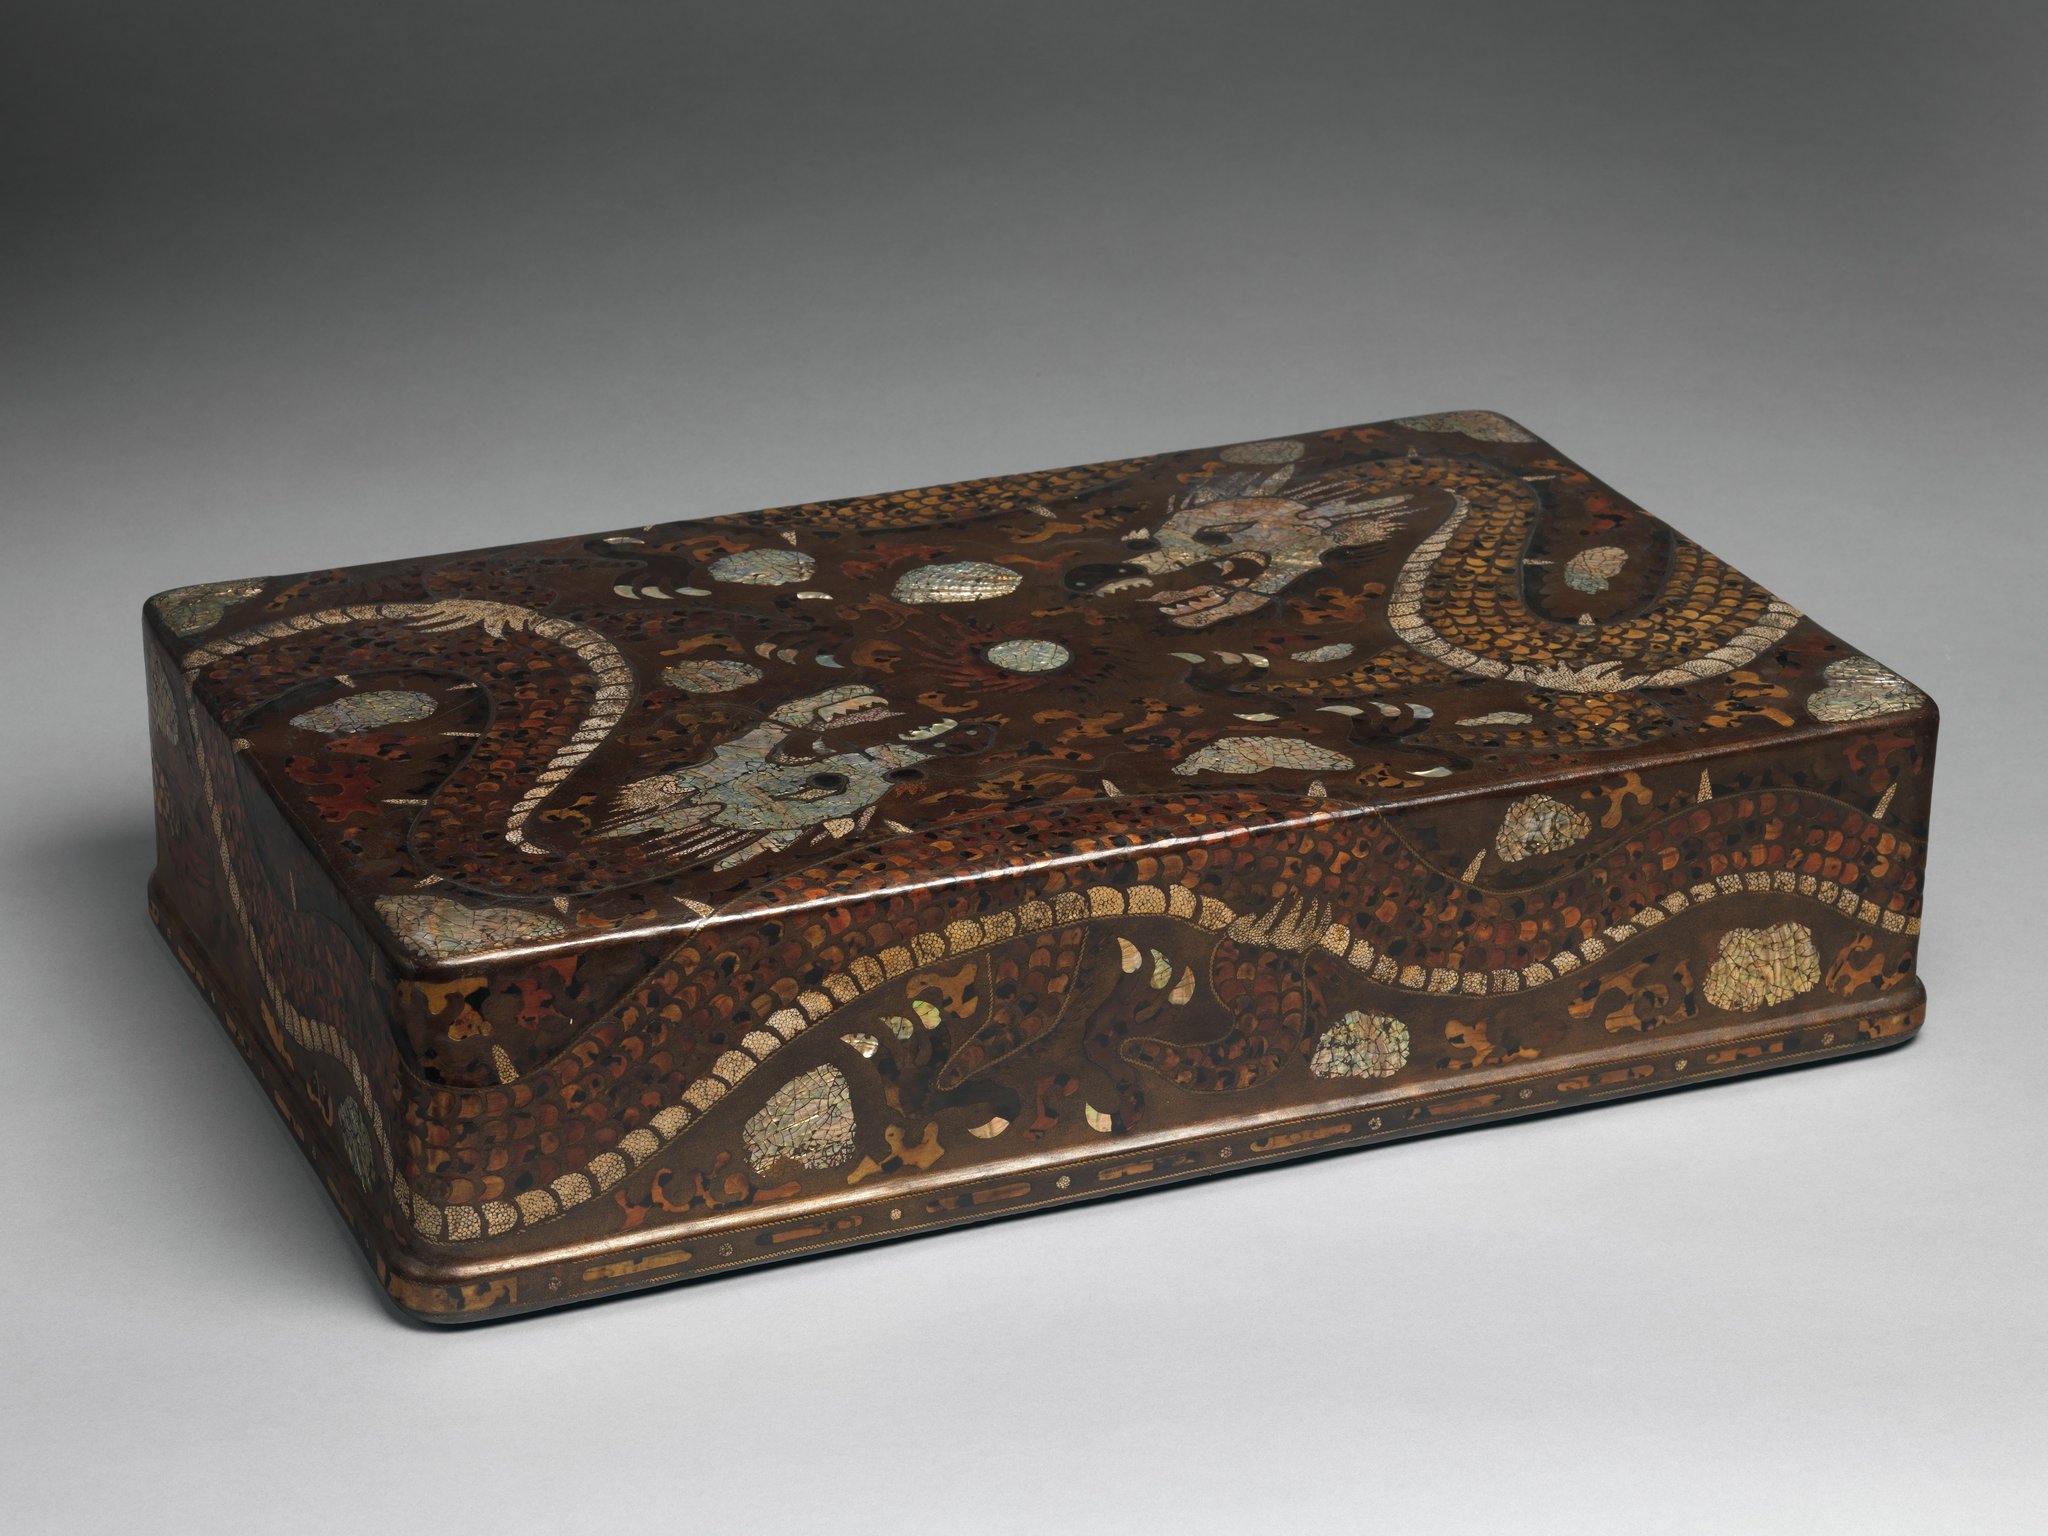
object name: clothing box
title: Clothing box decorated with dragons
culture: korean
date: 1801-1900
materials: lacquer, mother of pearl, skin, shell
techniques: inlay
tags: dragons